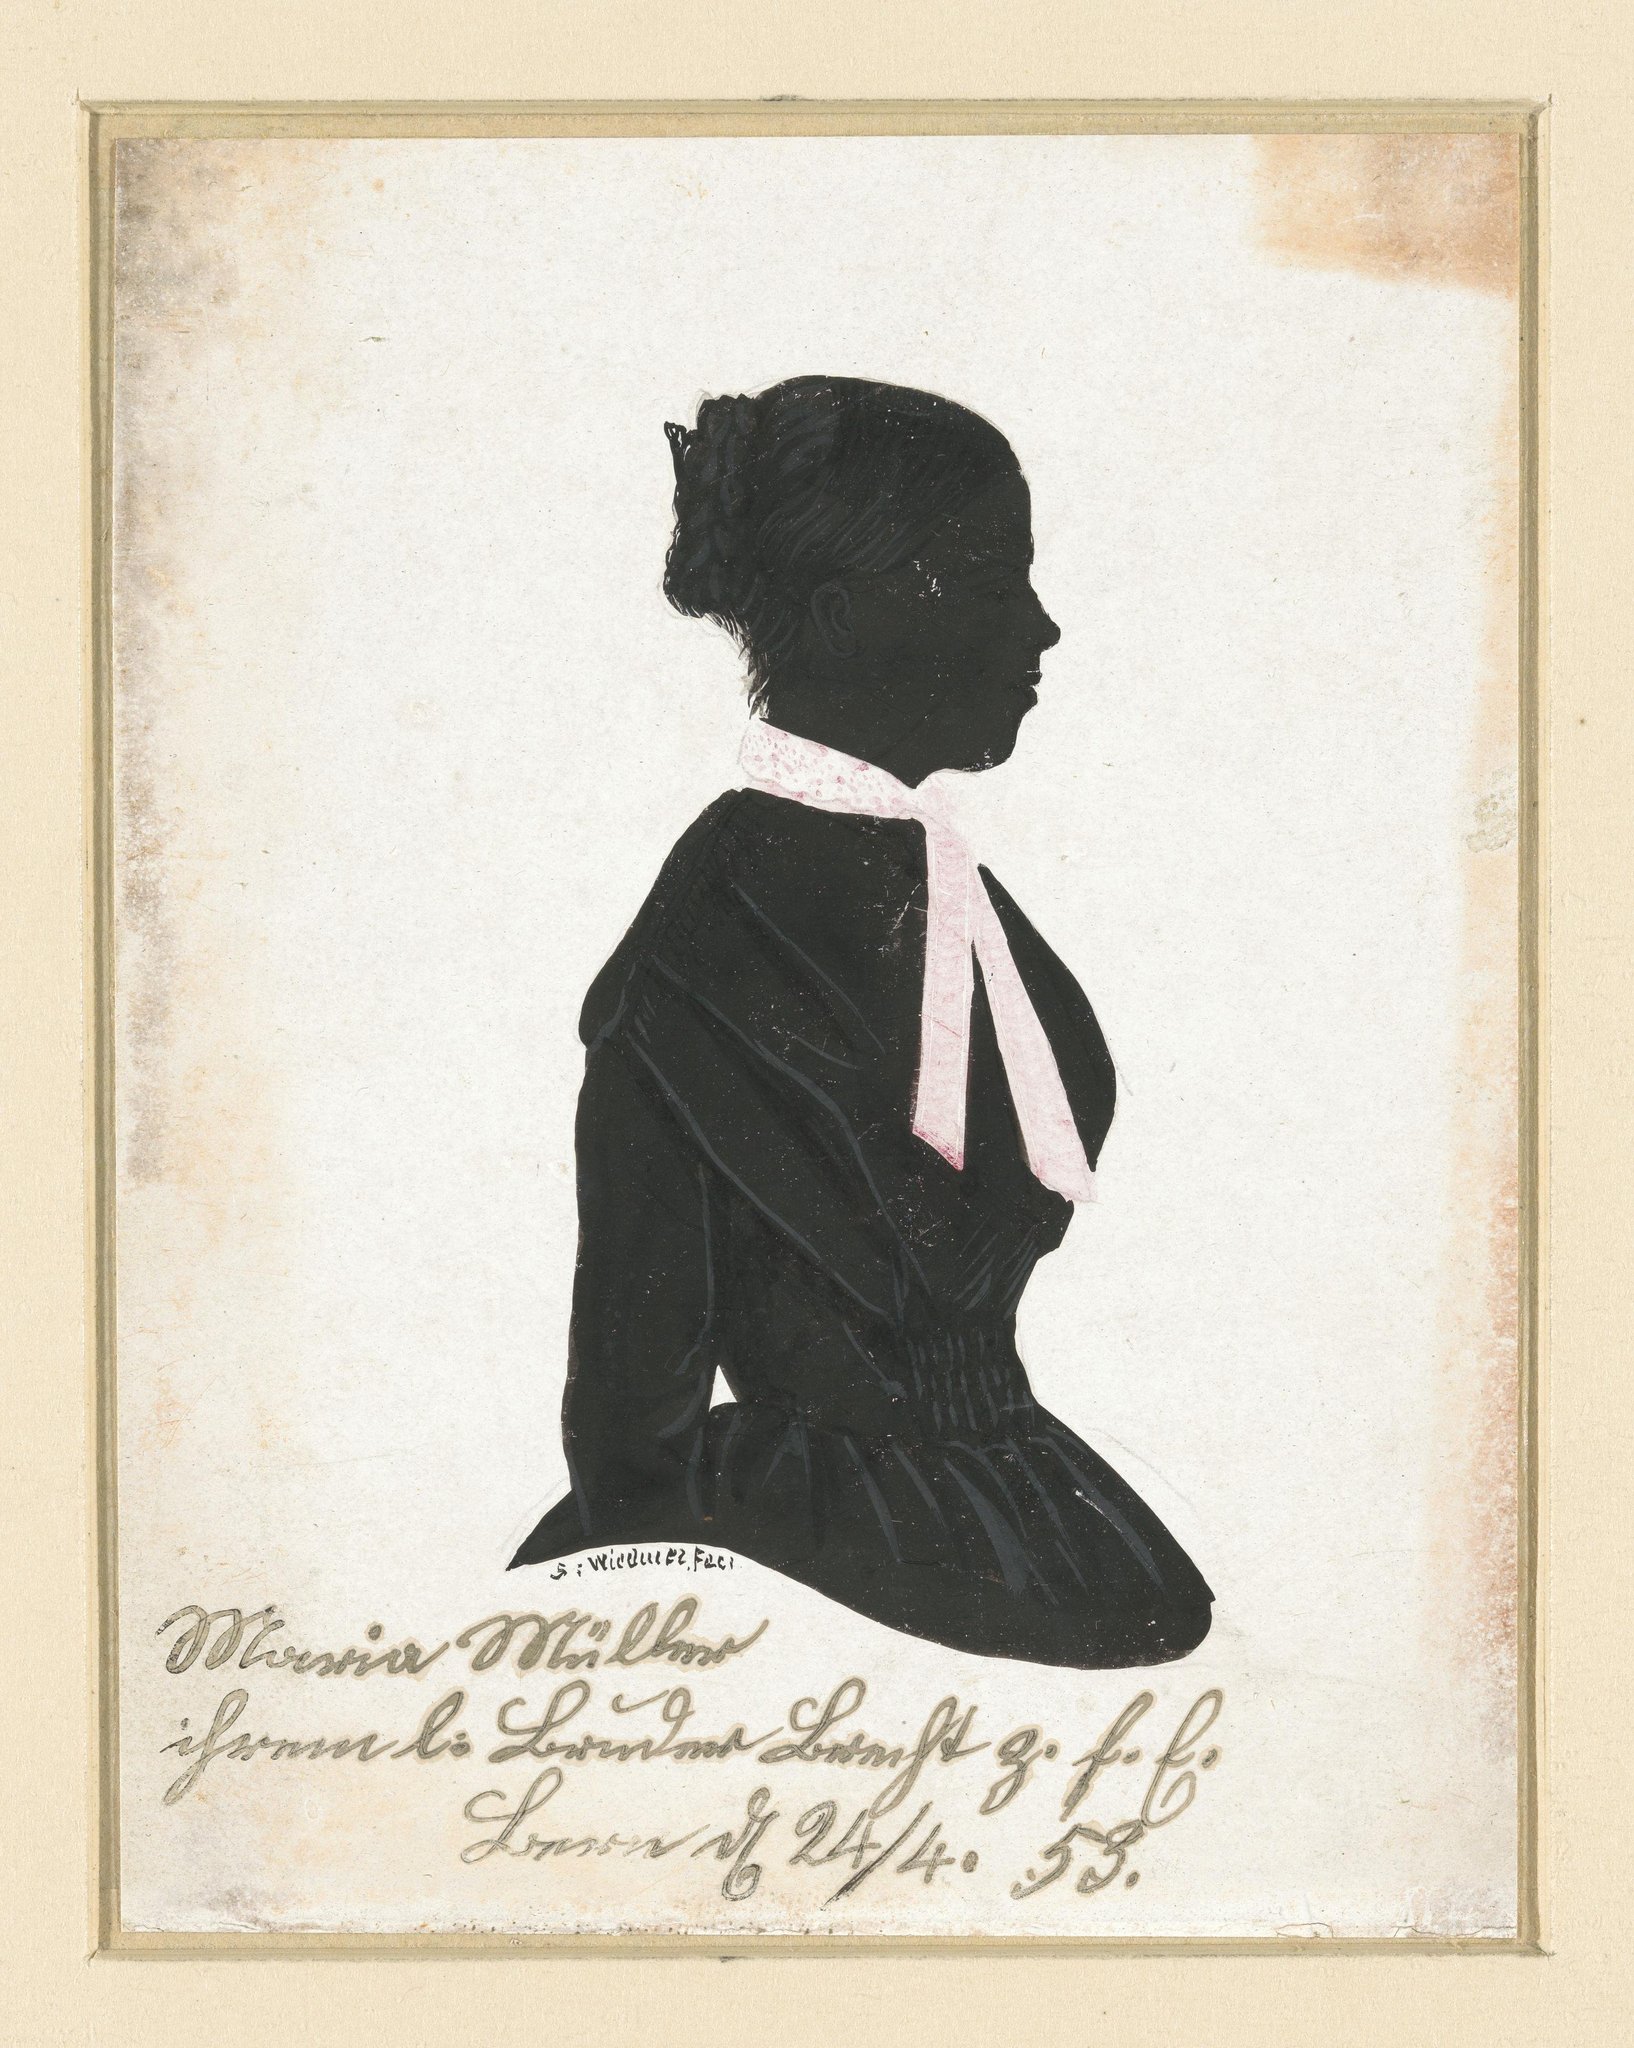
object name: drawing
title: Silhouet-portretje van Maria Müller met opgestoken vlecht, naar rechts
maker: s. wiedmer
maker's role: draughtsman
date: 1853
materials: paper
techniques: brush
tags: maria müller